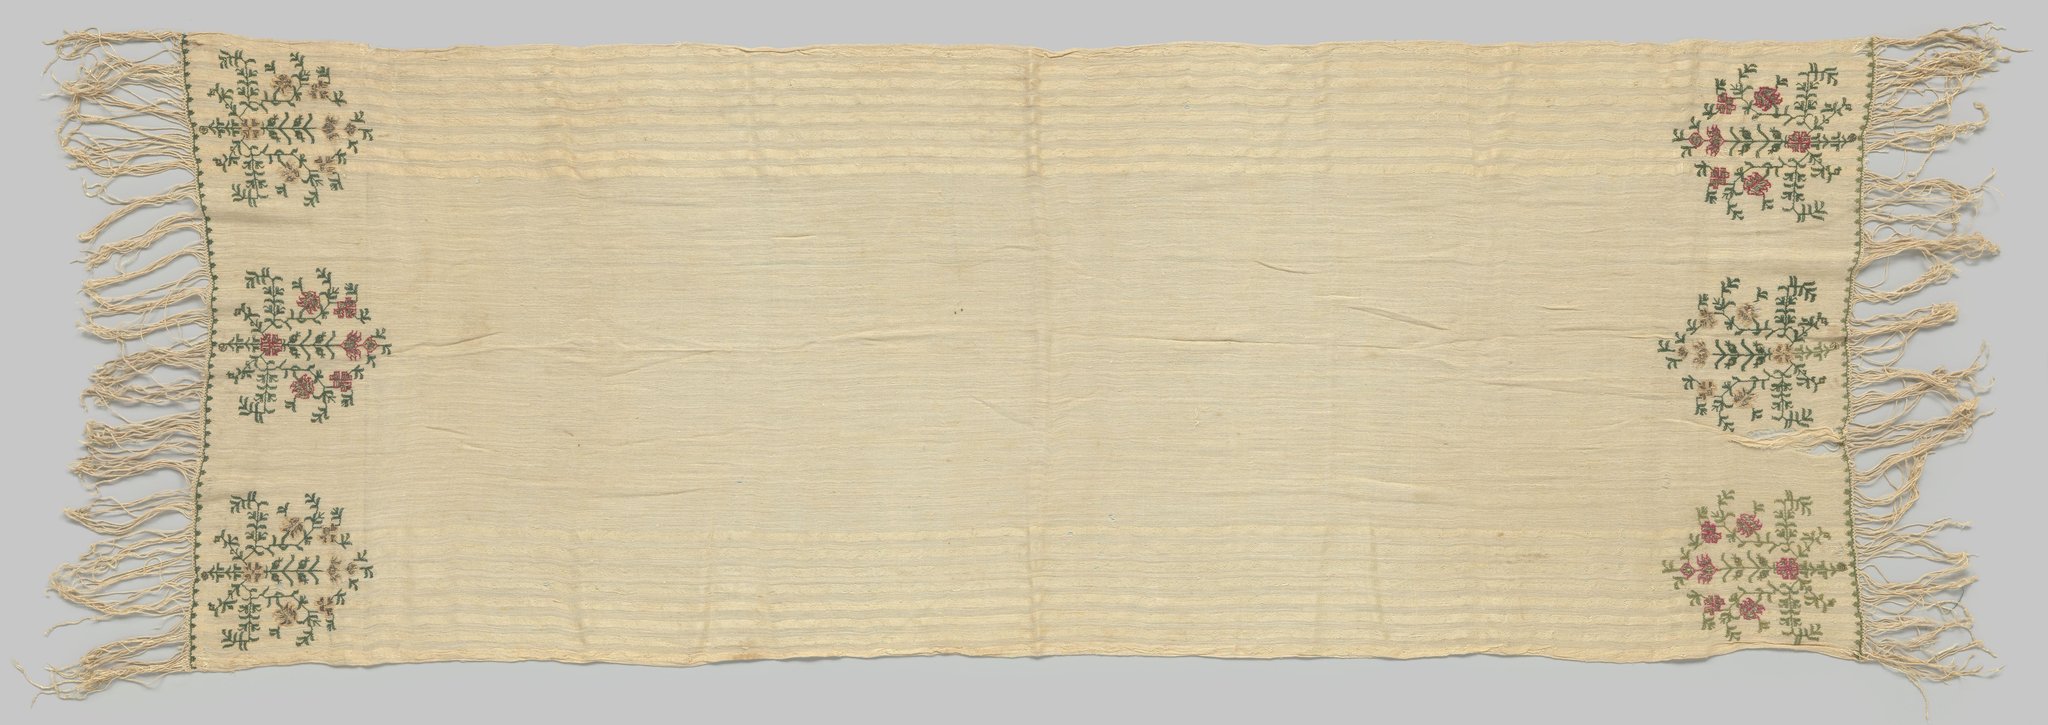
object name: scarf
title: Langwerpige sjaal van wit katoen met ingeweven zijden strepen en versierd met een rand van licht- en donkergroene takken, elk met zes beige en roodgerande zilveren bloemen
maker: Anonymous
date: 1800-1900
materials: cotton, silk, thread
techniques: embroidered, weave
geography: turkey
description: Langwerpige sjaal van wit katoen met ingeweven zijden strepen en versierd met een rand van licht- en donkergroene takken, elk met zes beige en roodgerande zilveren bloemen. Franjes langs de korte zijde. Mogelijk bruidskleding, een bruidshoofddoek.